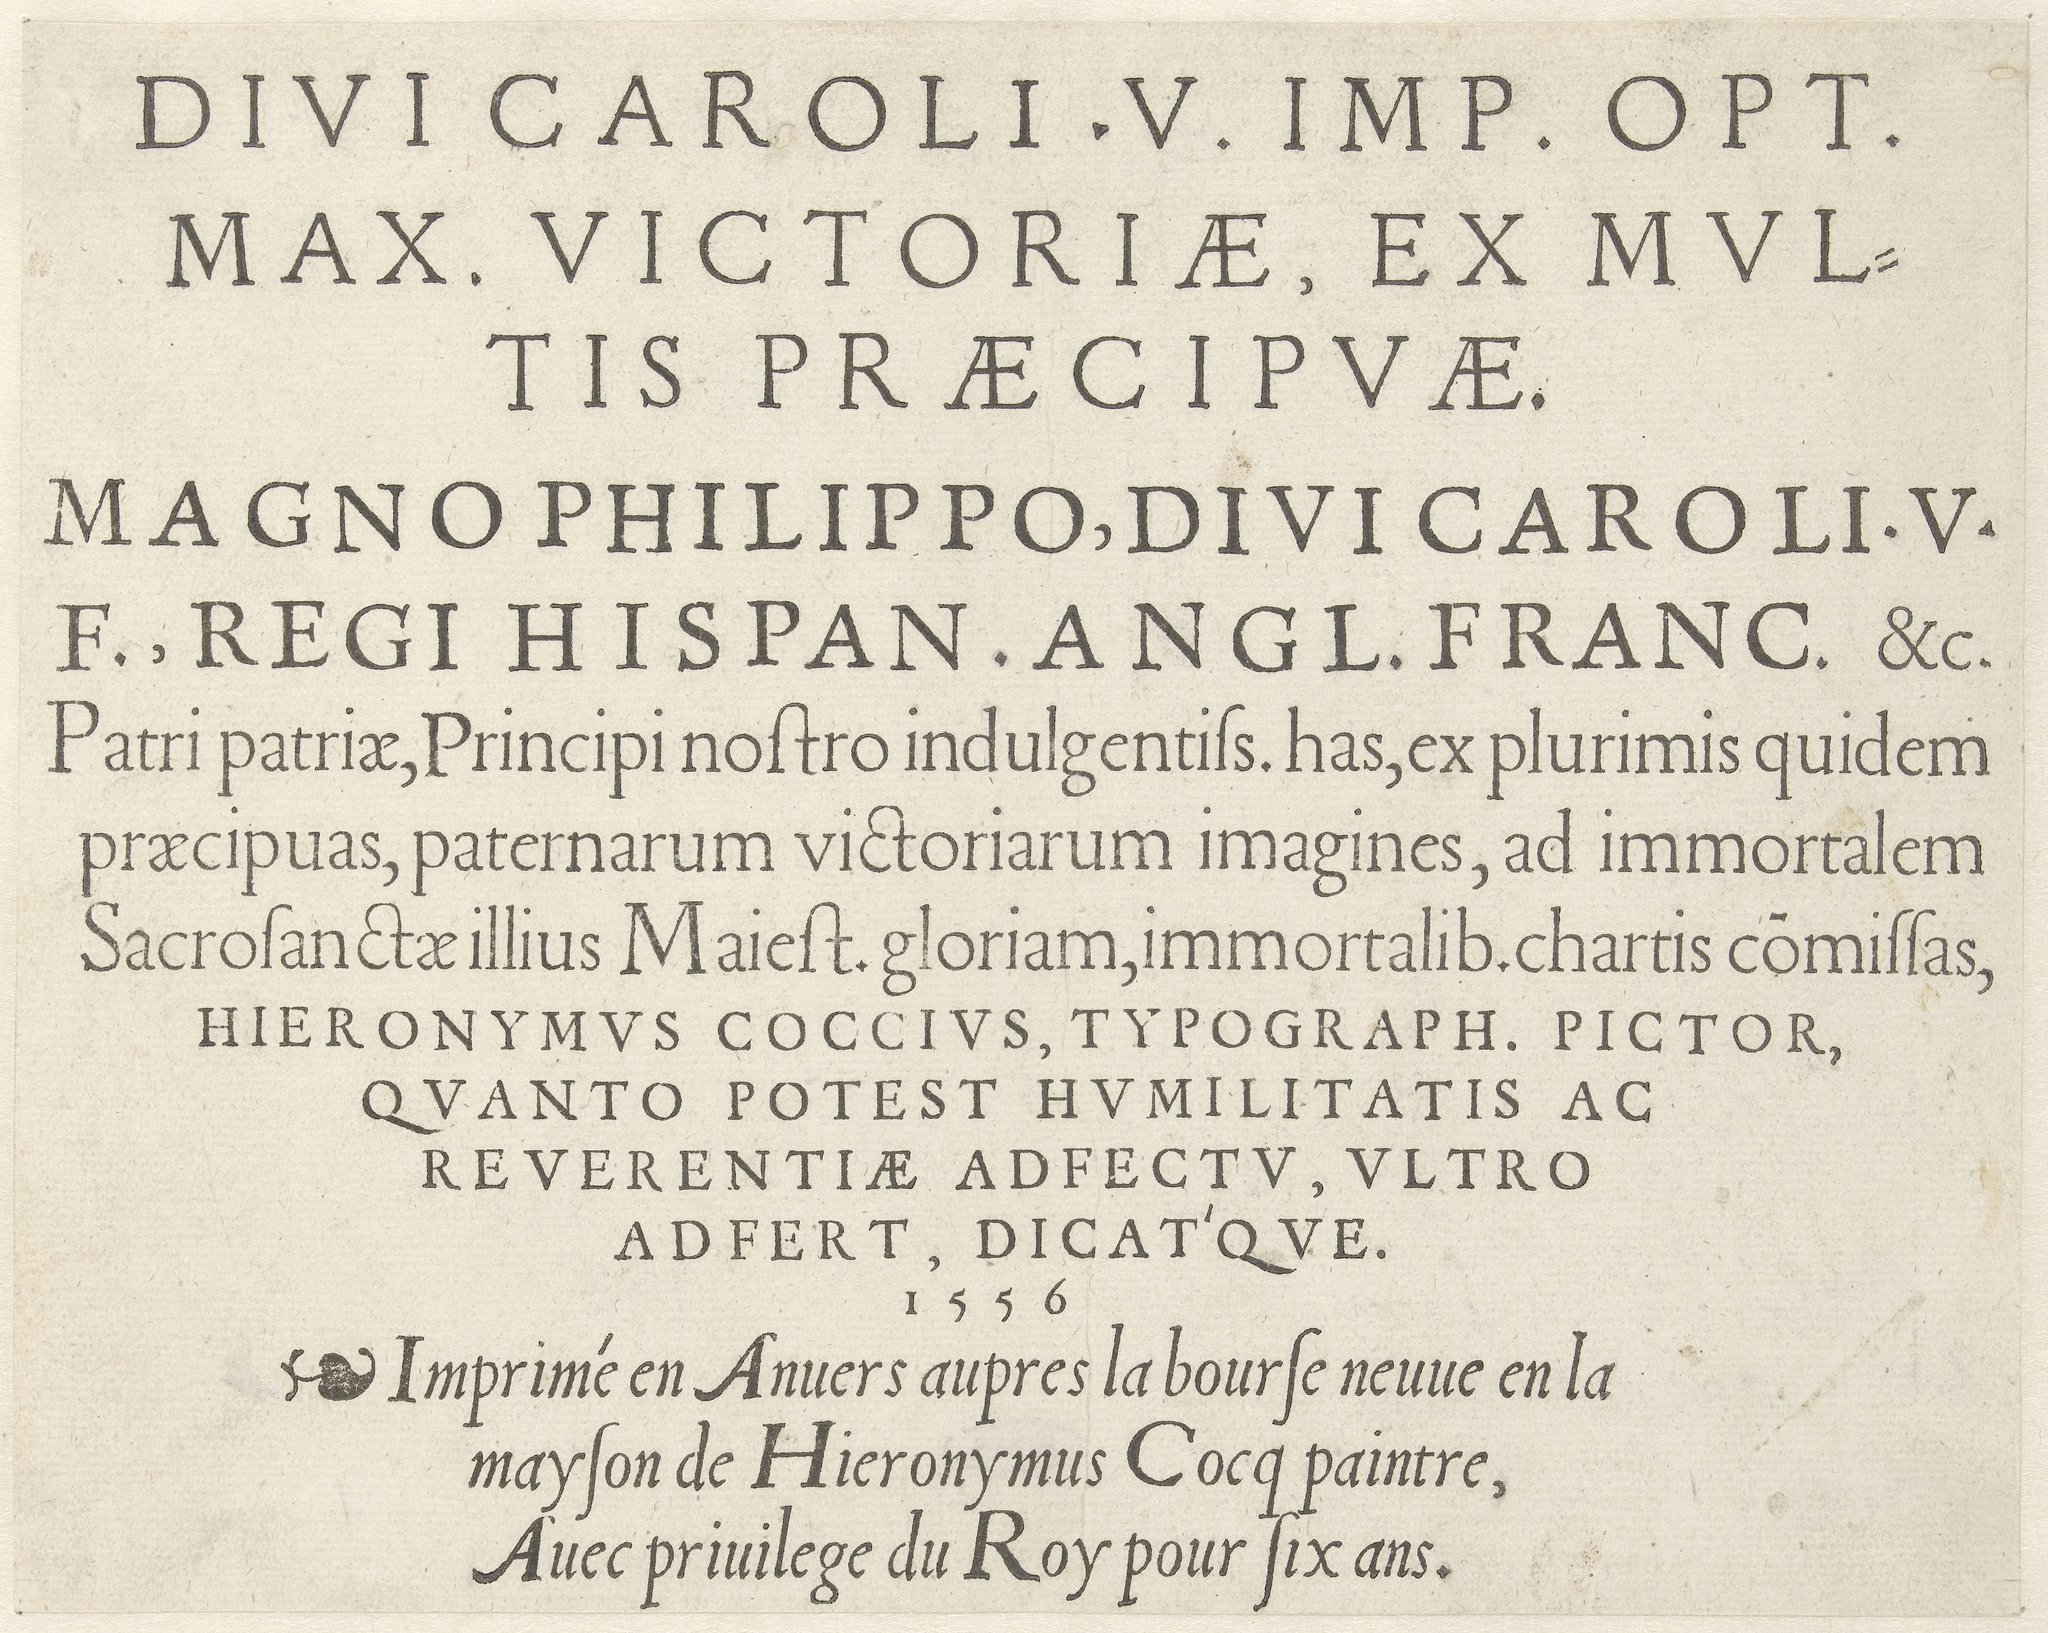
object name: print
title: Divi Caroli. V. imp. opt. max. victoriae, ex mvltis praecipvae.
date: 1556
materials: paper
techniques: letterpress printing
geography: brussels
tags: philip ii of spain, ghent, charles v (holy roman emperor and king of spain)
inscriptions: collector's mark: Lugt 2228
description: Titelprent voor een genummerde twaalfdelige serie over de overwinningen van keizer Karel V. De tekst is in het Latijn